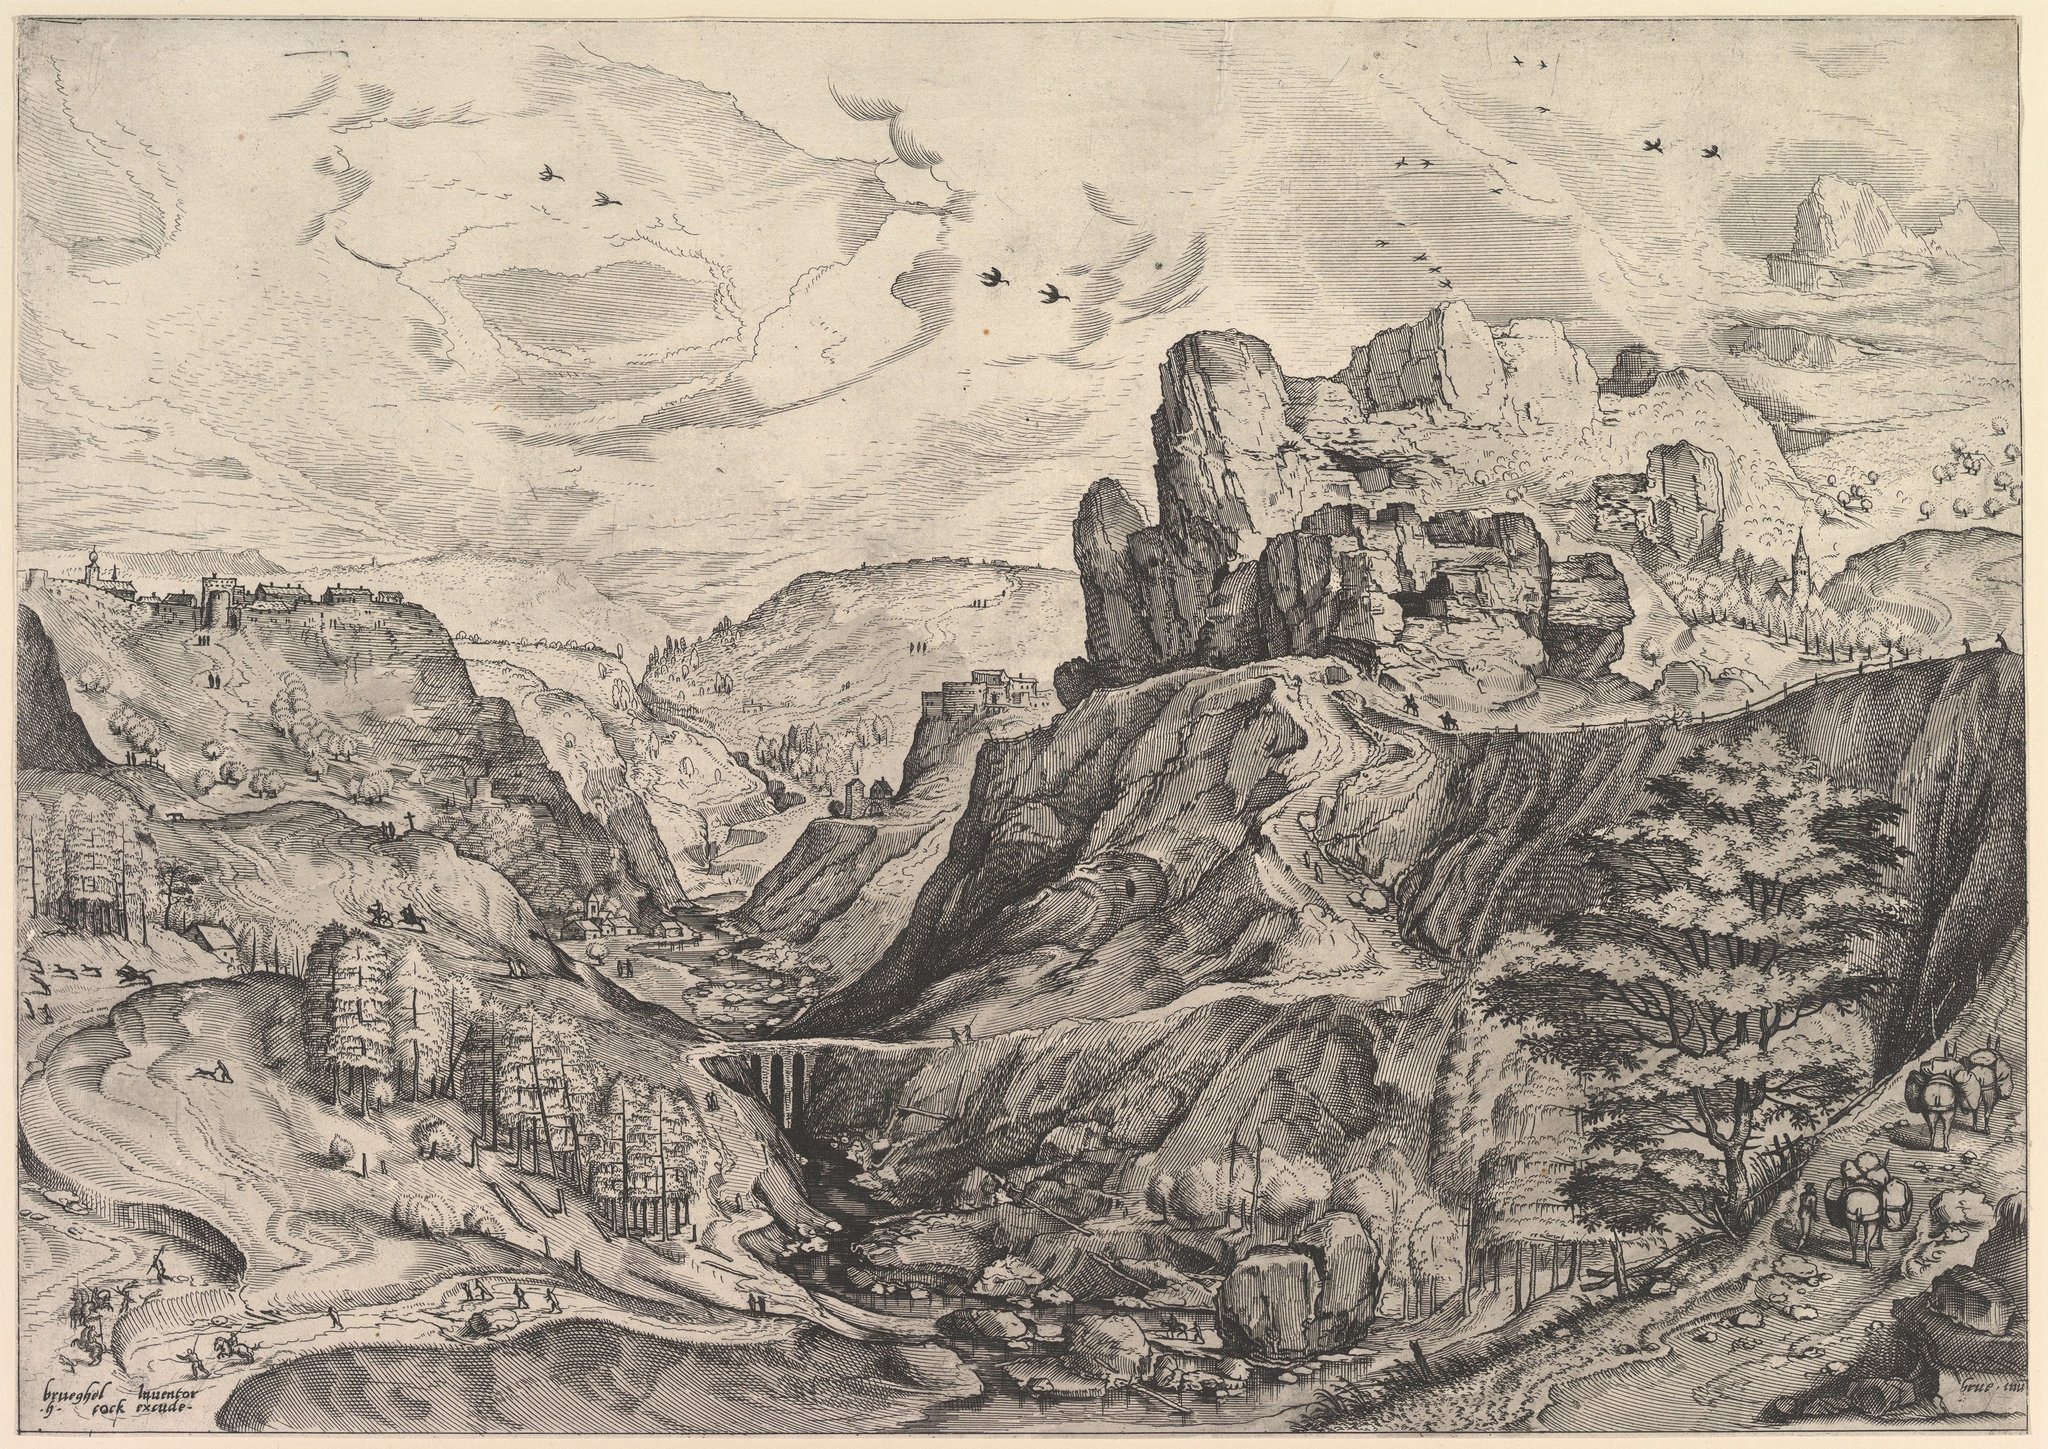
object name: print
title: Alpine Landscape with a Deep Valley, from "The Large Landscapes"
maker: johannes van doetecum i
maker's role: artist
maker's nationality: netherlandish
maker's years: 1528-1605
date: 1555-1556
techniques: engraving, etching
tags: hills,landscapes,trees